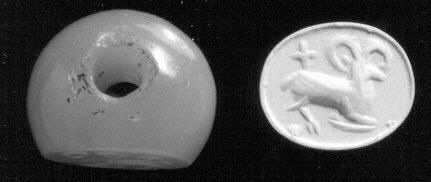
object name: stamp seal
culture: sasanian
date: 201-700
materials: stone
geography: iran or mesopotamia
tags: animals